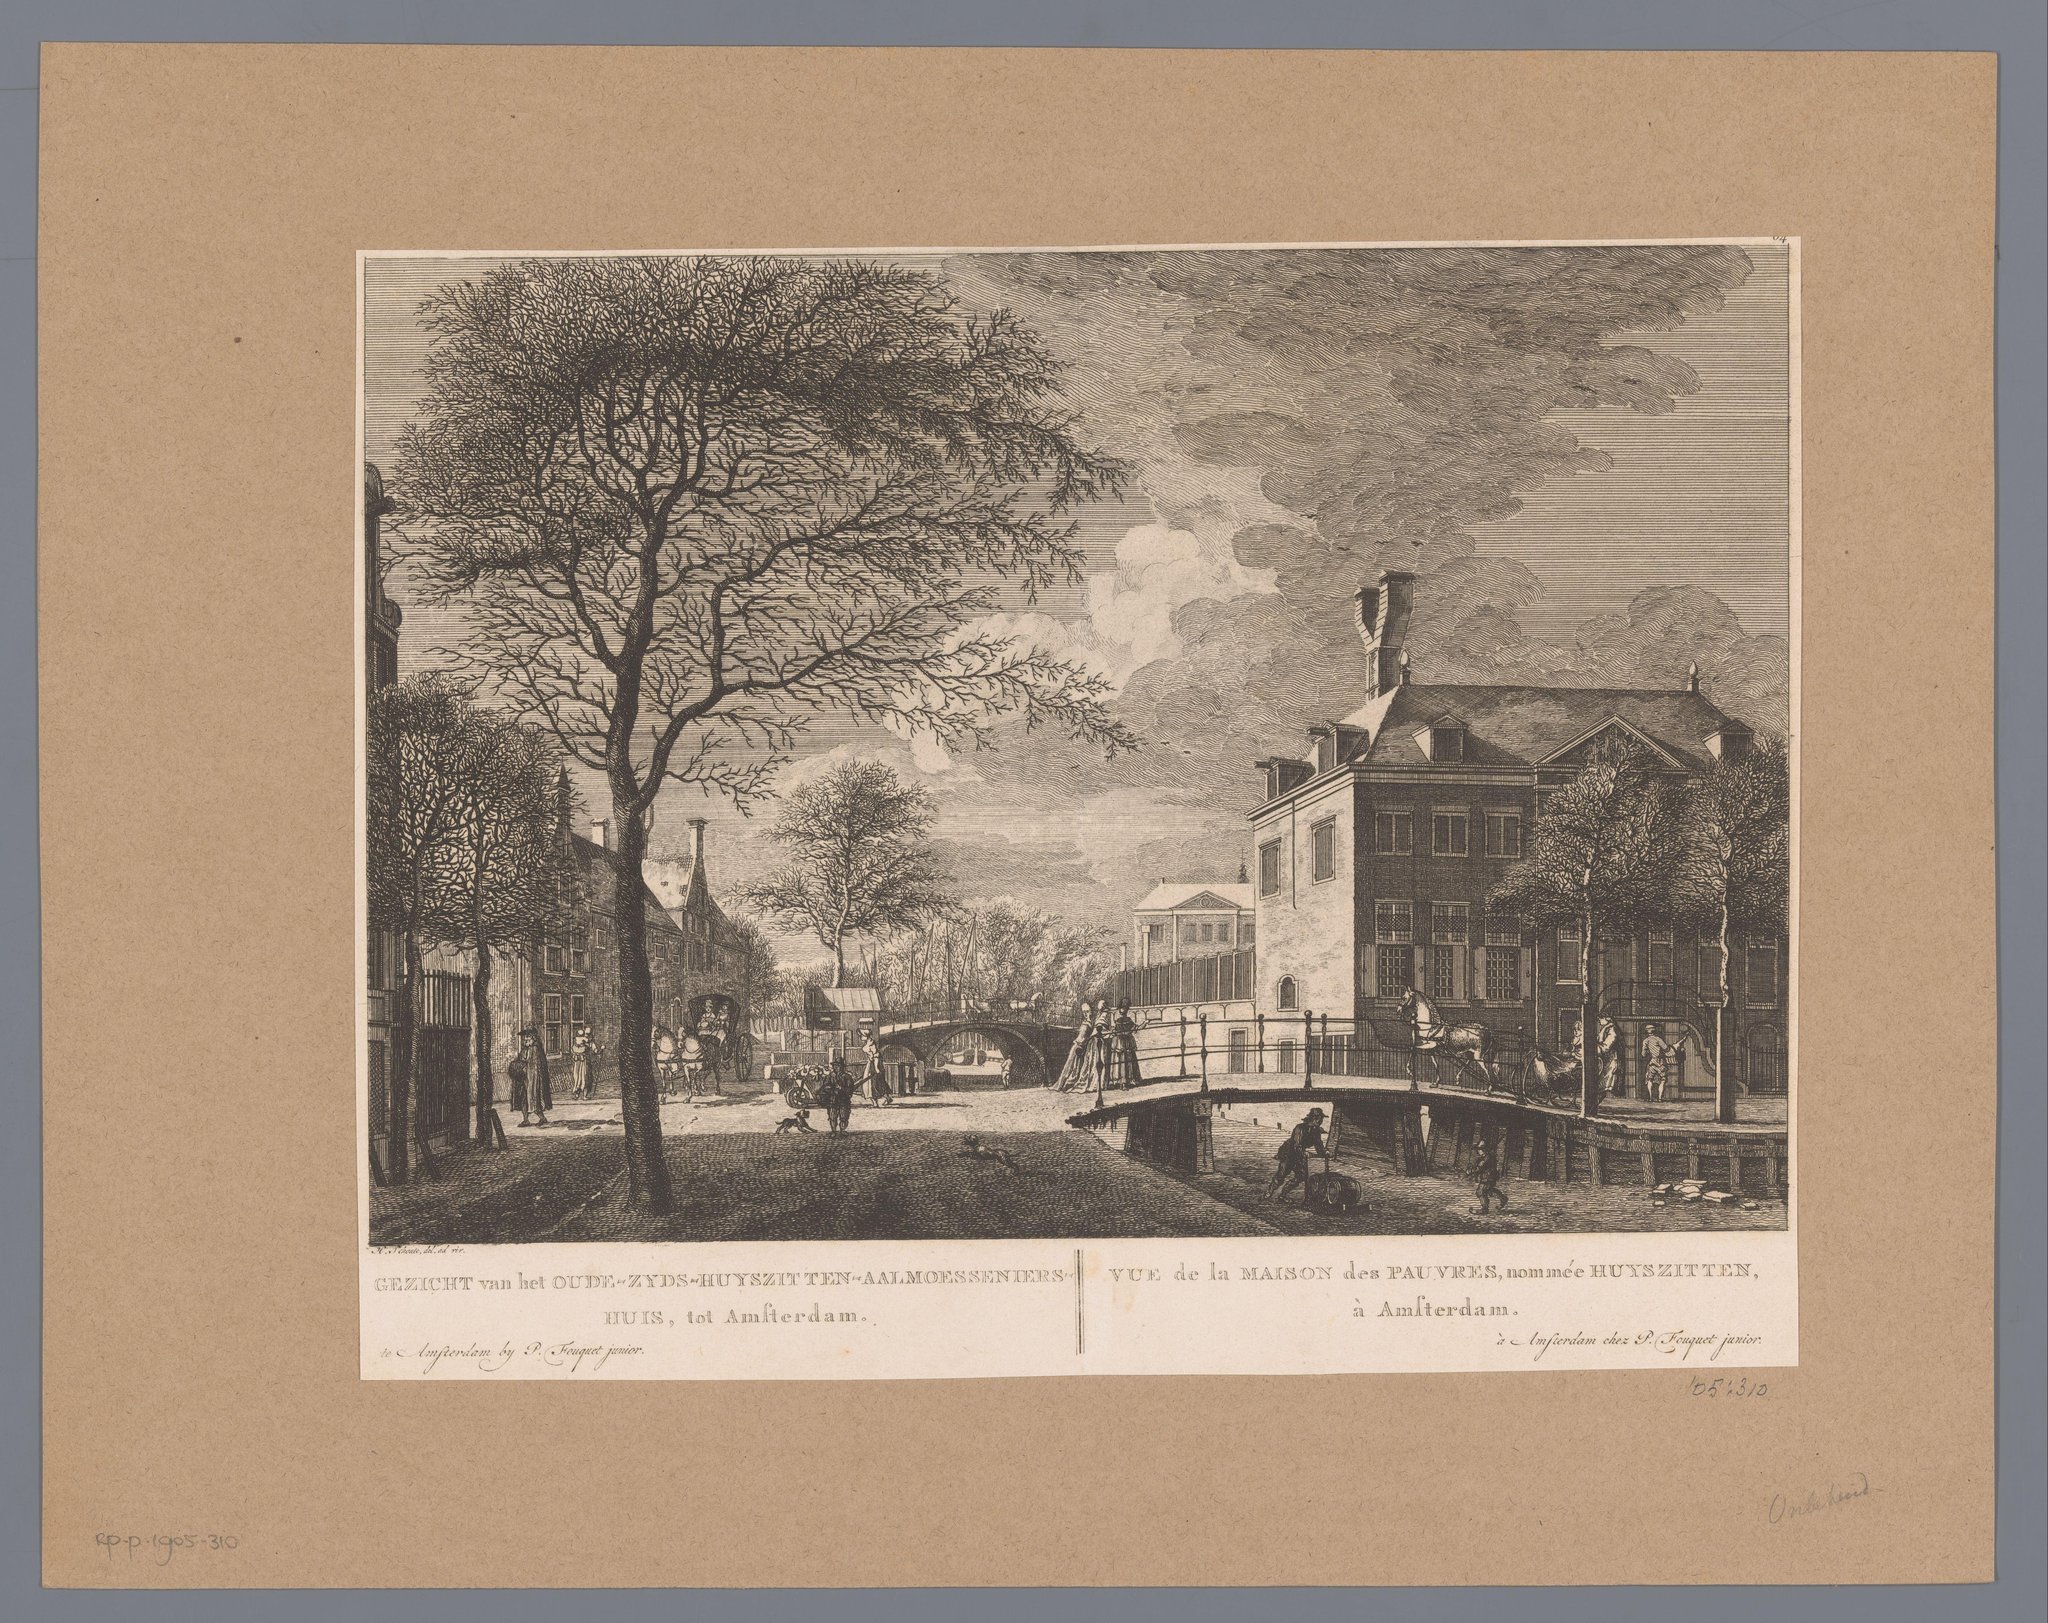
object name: book illustration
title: Gezicht van het Oude-zyds-huyszitten-aalmoesseniers-huis, tot Amsterdam / Vue de la Maison des Pauvres, nommée Huyszitten, à Amsterdam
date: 1778-1783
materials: paper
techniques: engraving, etching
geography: amsterdam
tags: alms-house (dutch: 'hofje')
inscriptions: collector's mark: Lugt 2228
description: Prent uit een van de edities van de Atlas Fouquet: Afbeeldingen van de wyd-vermaarde koopstad Amsterdam benevens des zelvs voornaamste gebouwen en gezigten alle naar het leeven getekend / Receuil des edifices les plus considerables et des plus belles vues, de la fameuse ville d'Amsterdam, dessinées d'après nature. Amsterdam: Pierre Fouquet, 1778-1783. En: Nieuwe atlas, van de voornaamste gebouwen en gezigten der stad Amsterdam, met derzelver beknopte beschryvingen. 2 dln. Amsterdam: Daniël Jean Changuion en Petrus den Hengst [in opdracht van Pierre Fouquet], 1783. Een latere staat komt voor in: Nieuwe atlas, van de voornaamste gebouwen en gezigten der stad Amsterdam. Met derzelver beknopte beschryvingen. Amsterdam: Evert Maaskamp, 1805.